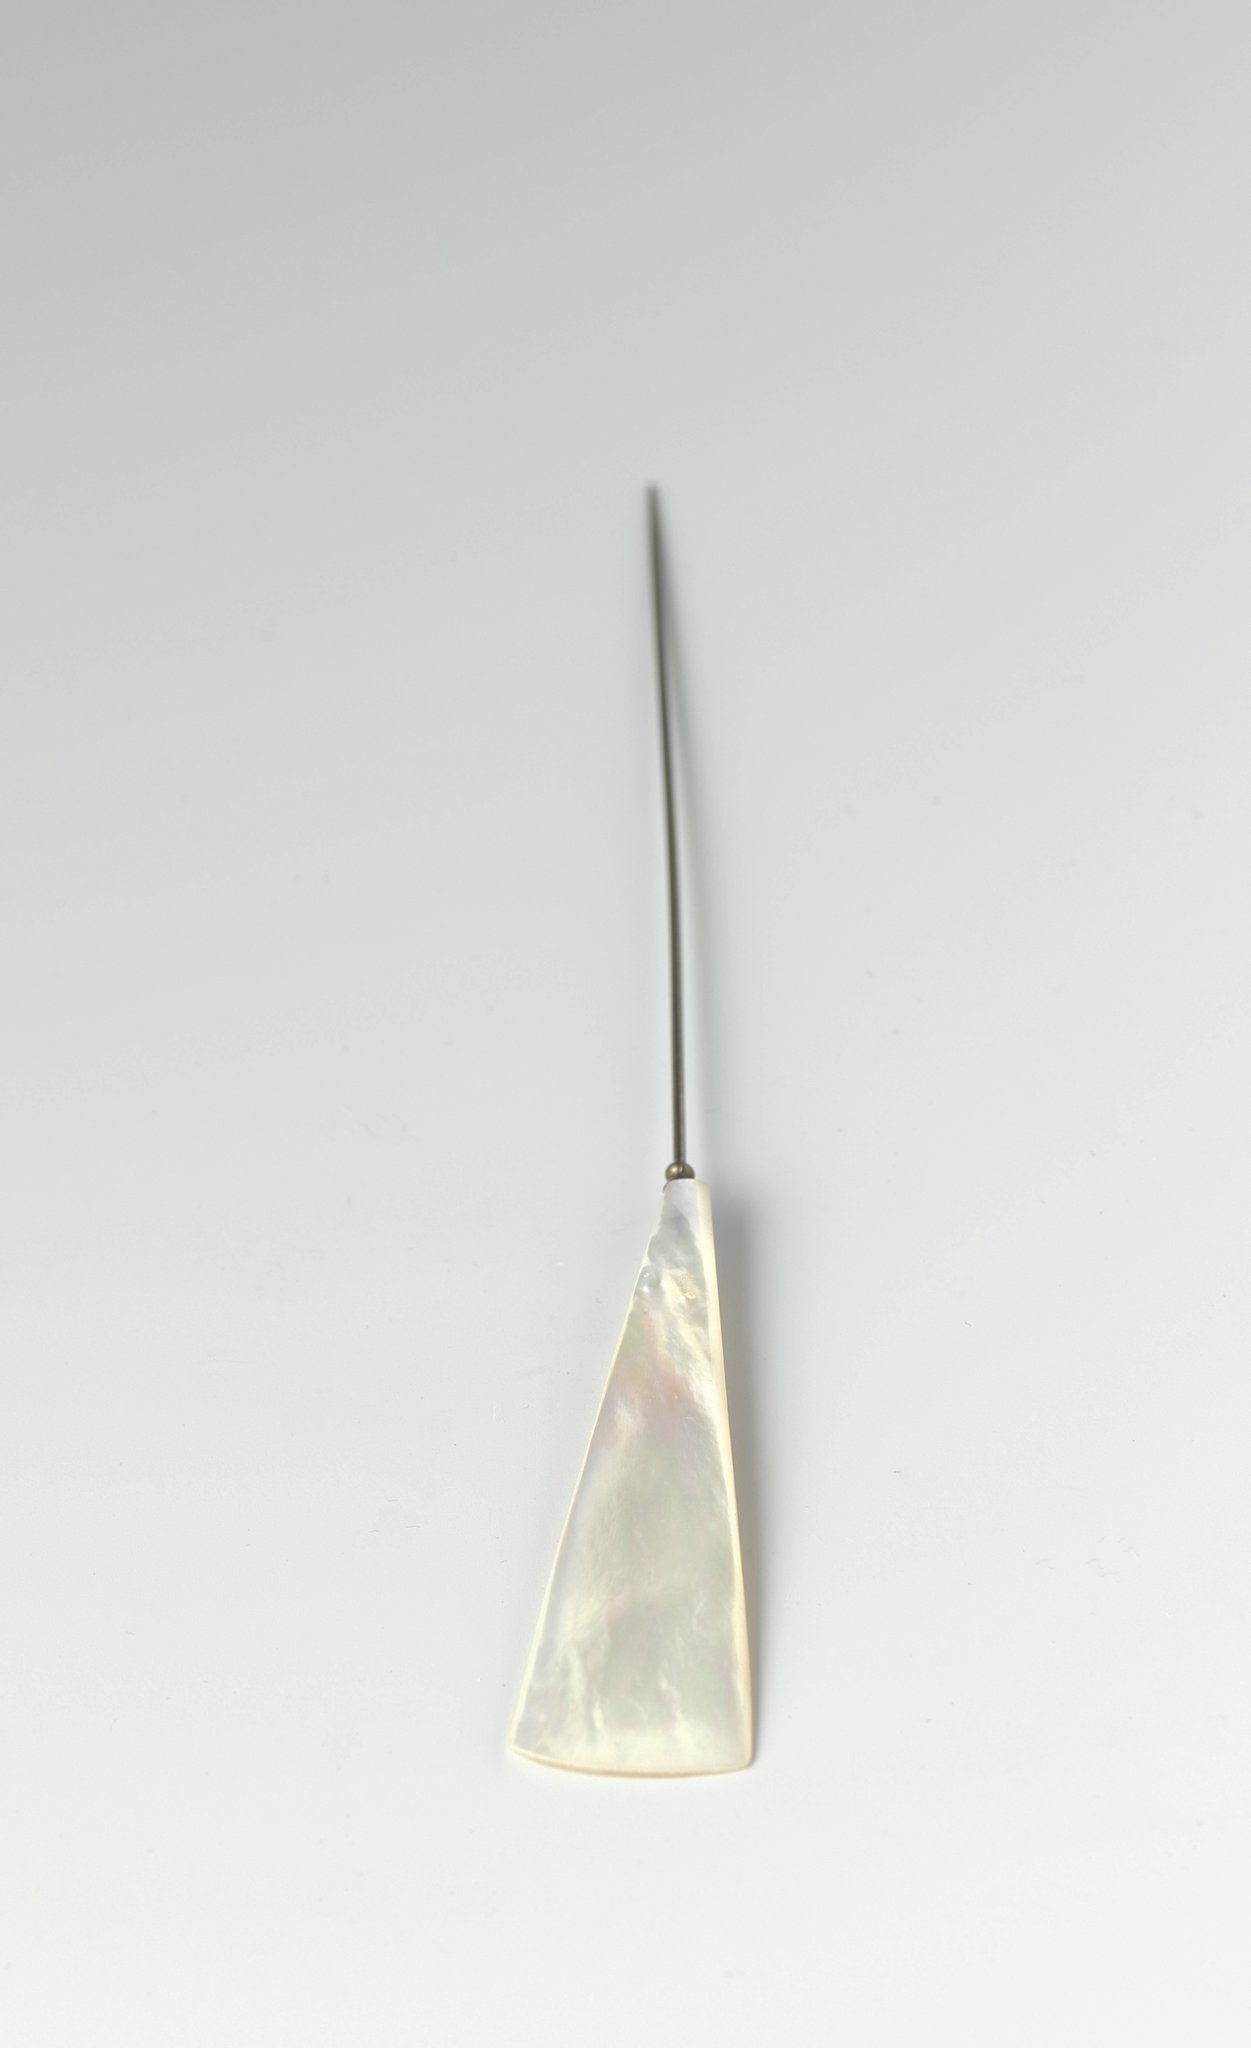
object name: hatpin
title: Hoedenspeld met platte langwerpige driehoekige knop van parelmoer op een stalen pen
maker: Anonymous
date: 1930-1940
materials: mother of pearl, steel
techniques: cutting, forging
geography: netherlands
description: Hoedenspeld met platte langwerpige driehoekige knop van parelmoer op een stalen pen.